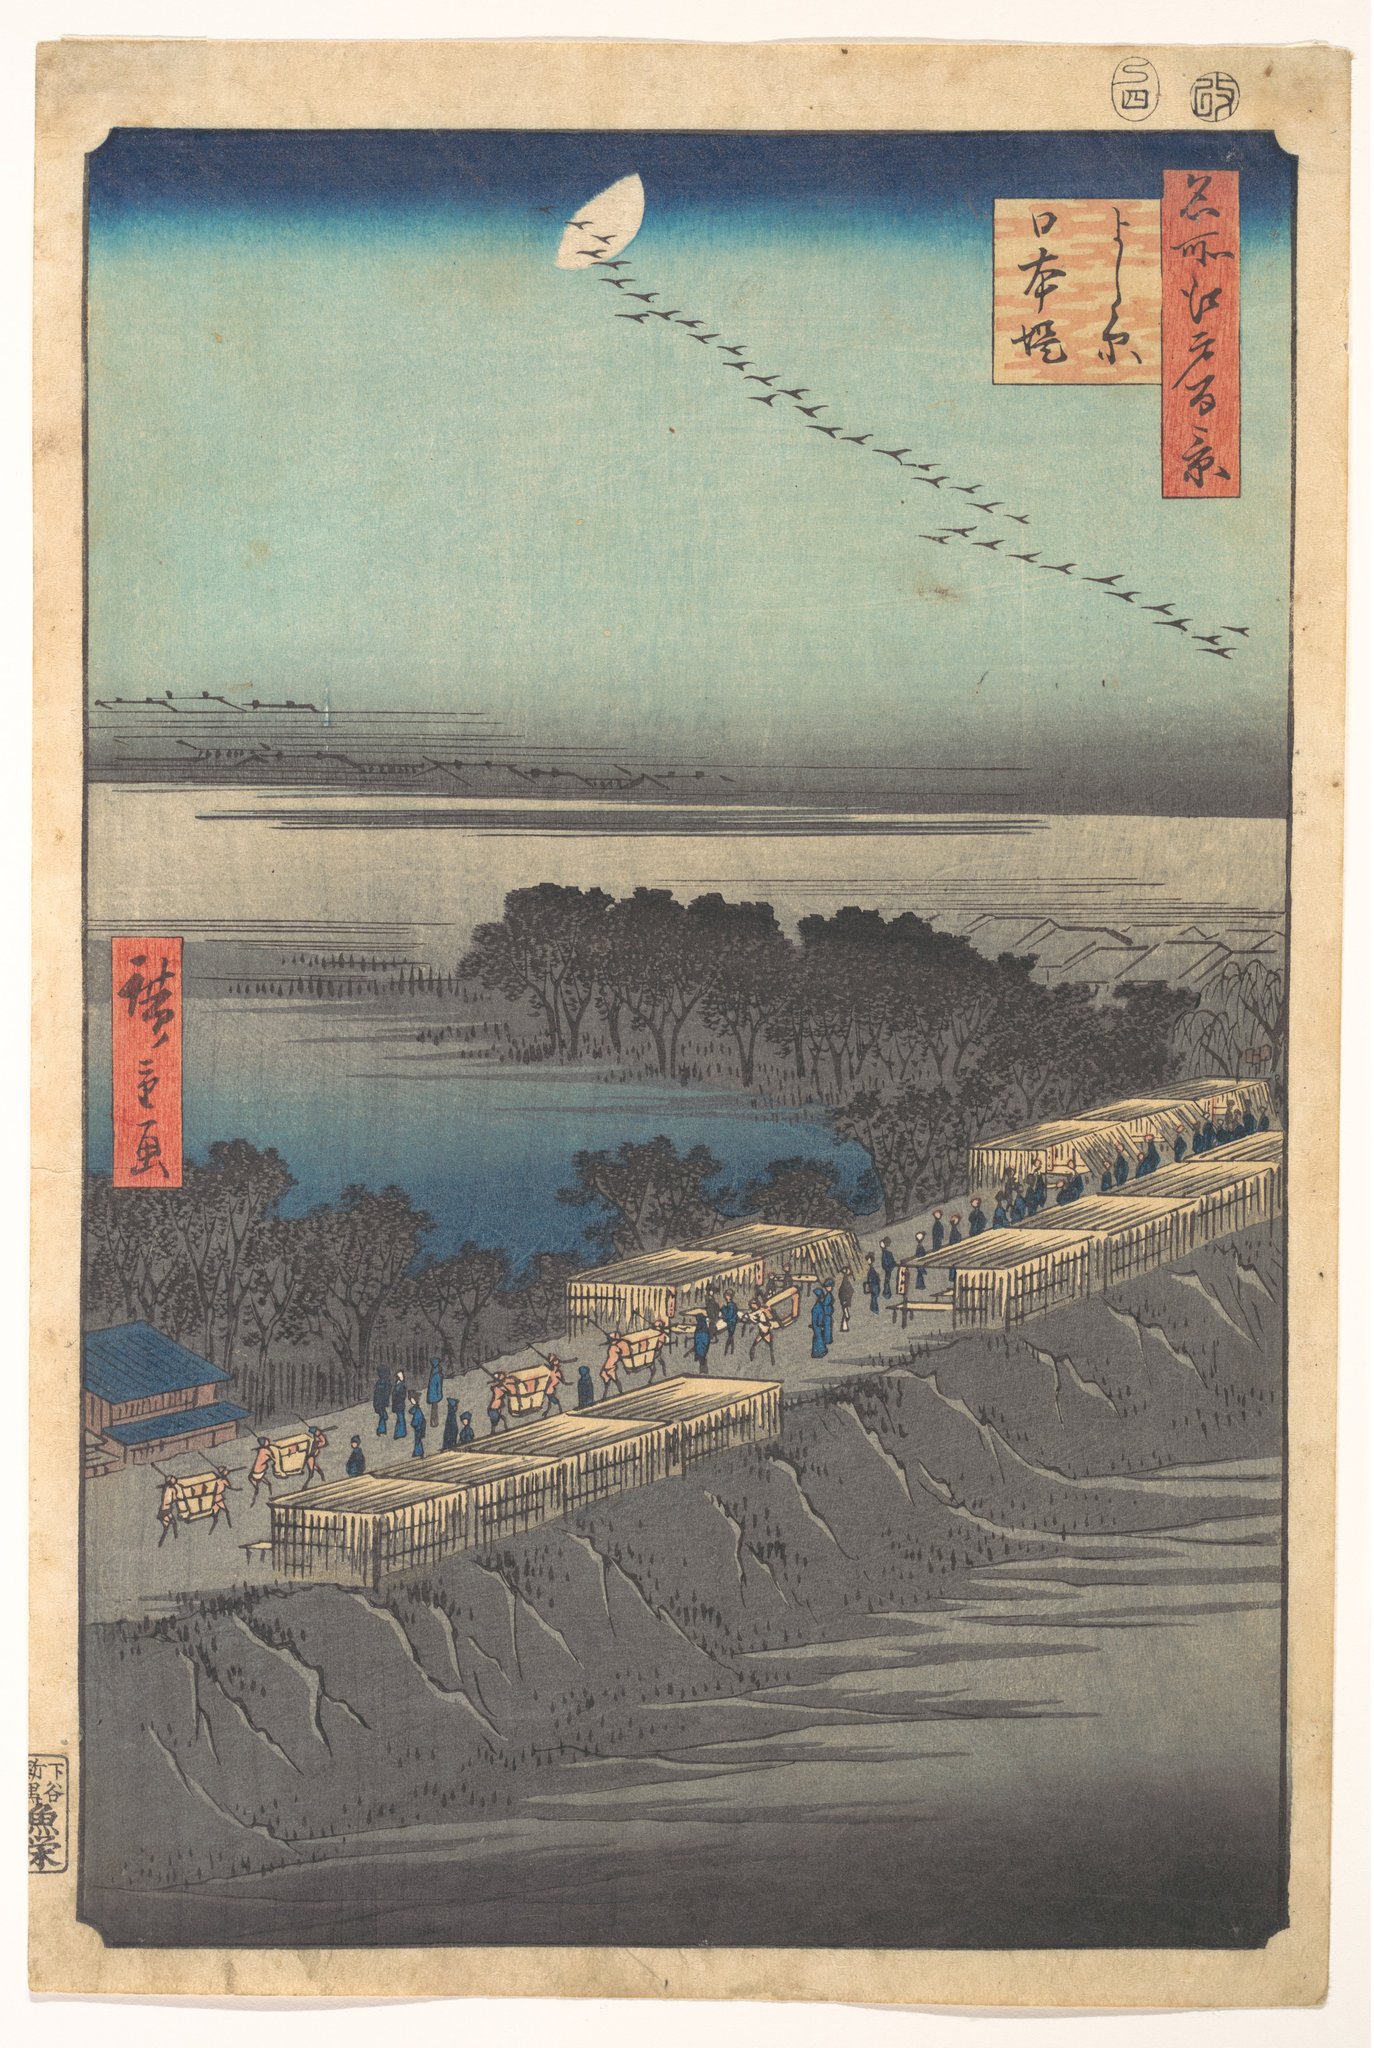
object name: print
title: “Nihon Embankment at Yoshiwara,” from the series One Hundred Famous Views of Edo (Meisho Edo hyakkei, Yoshiwara, Nihonzutsumi)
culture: japanese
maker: utagawa hiroshige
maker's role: artist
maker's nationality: japanese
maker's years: 1797-1858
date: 1857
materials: ink, paper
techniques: woodblock print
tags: human figures,birds,moon,landscapes,trees